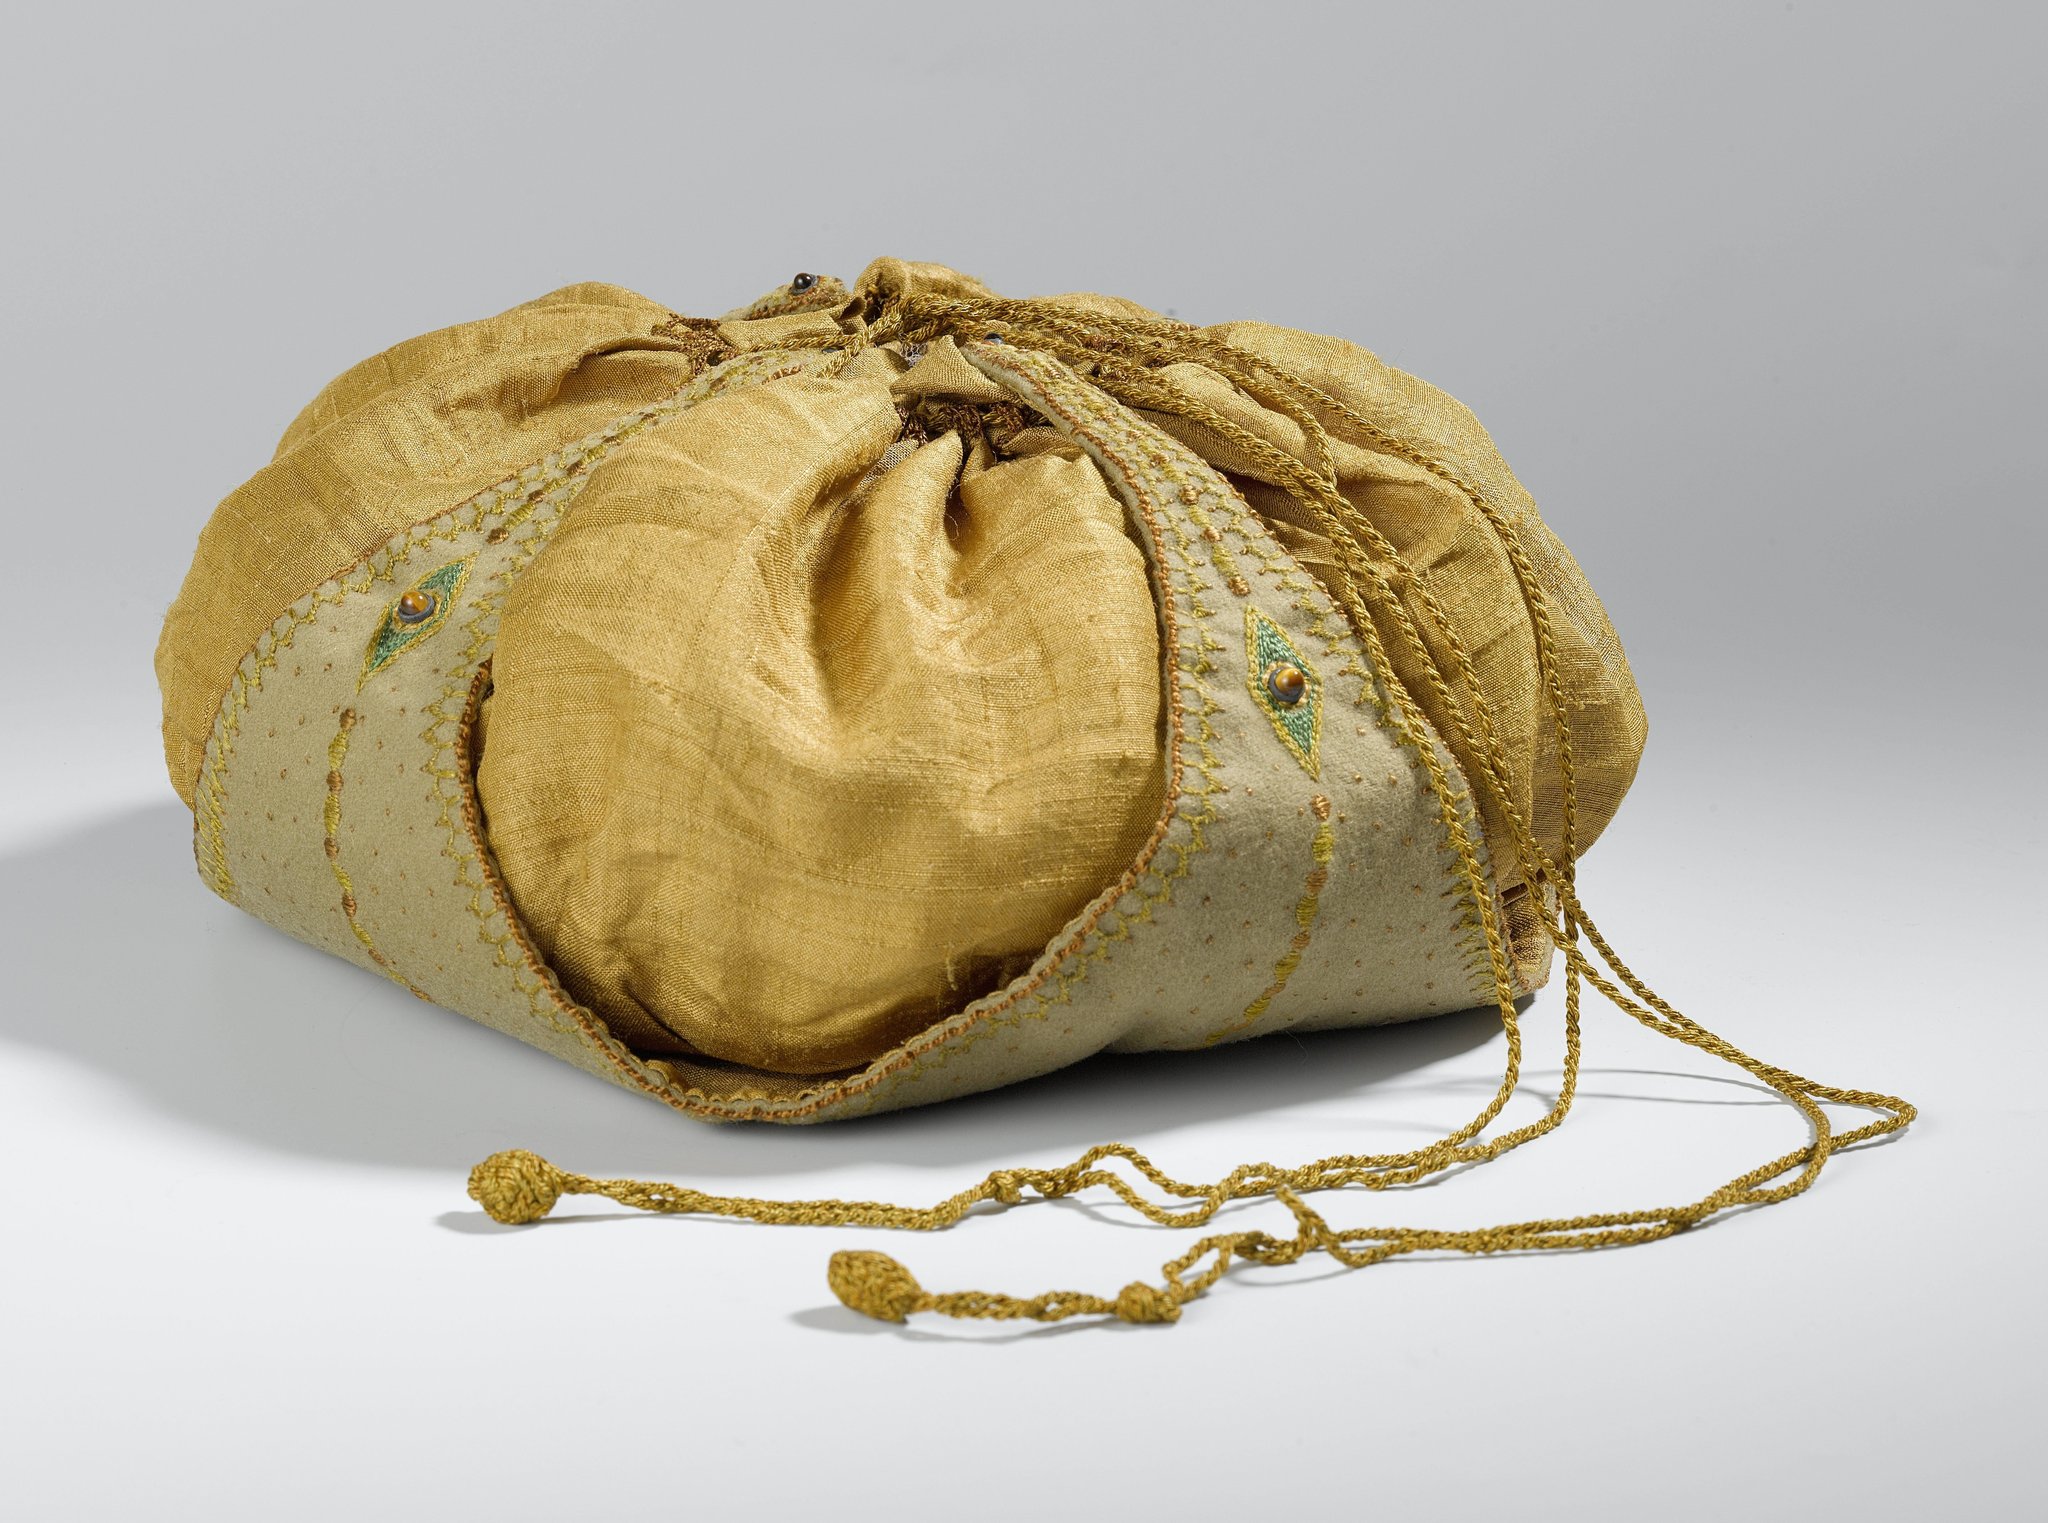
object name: purse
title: Ronde buidel van okergele shantungzijde, waaromheen een vierkant vlak van geborduurde groen-grijze geruwde wol versierd met tijgeroog kralen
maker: Anonymous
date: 1910-1920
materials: silk, gemstone, wool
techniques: embroidered, turning, weave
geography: netherlands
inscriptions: circumscription: ‘'no 23', tasch. / draaqmotief / nog verder opgevoerd'’, name: ‘'Van Reesema', 'Nierstrasz' en 'NVDW'’, circumscription: ‘'Namaak verboden. Beschermd door de auteurswet'.’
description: Ronde buidel van okergele shantungzijde, waaromheen een vierkant vlak met uitwaaierende punten van geborduurde groen-grijze geruwde wol, gevoerd met okergele zijde. De vier punten zijn aan de bovenrand van de buidel vastgezet, met aan ieder uiteinde een tijgeroog kraal. De wol is versierd met kleine regelmatig verspreide punten en een geborduurde rand in goudgele en bruine vloszijde. In het midden een vierpuntige ster, waarbinnen een geborduurde cirkel in groen en bruin en een halfronde glazen kraal. Aan de punten van de ster een machinaal geborduurde lijn van ronde bruine dan wel langgerekte goudgele stippen, die uitkomt in de punten van het wollen vlak. Langs de rand van de tas een strook van gehaakte cirkels waar een dubbel goudgeel gedraaid koord doorheen geregen is, waarmee de tas gesloten kan worden. De tas is ongevoerd.